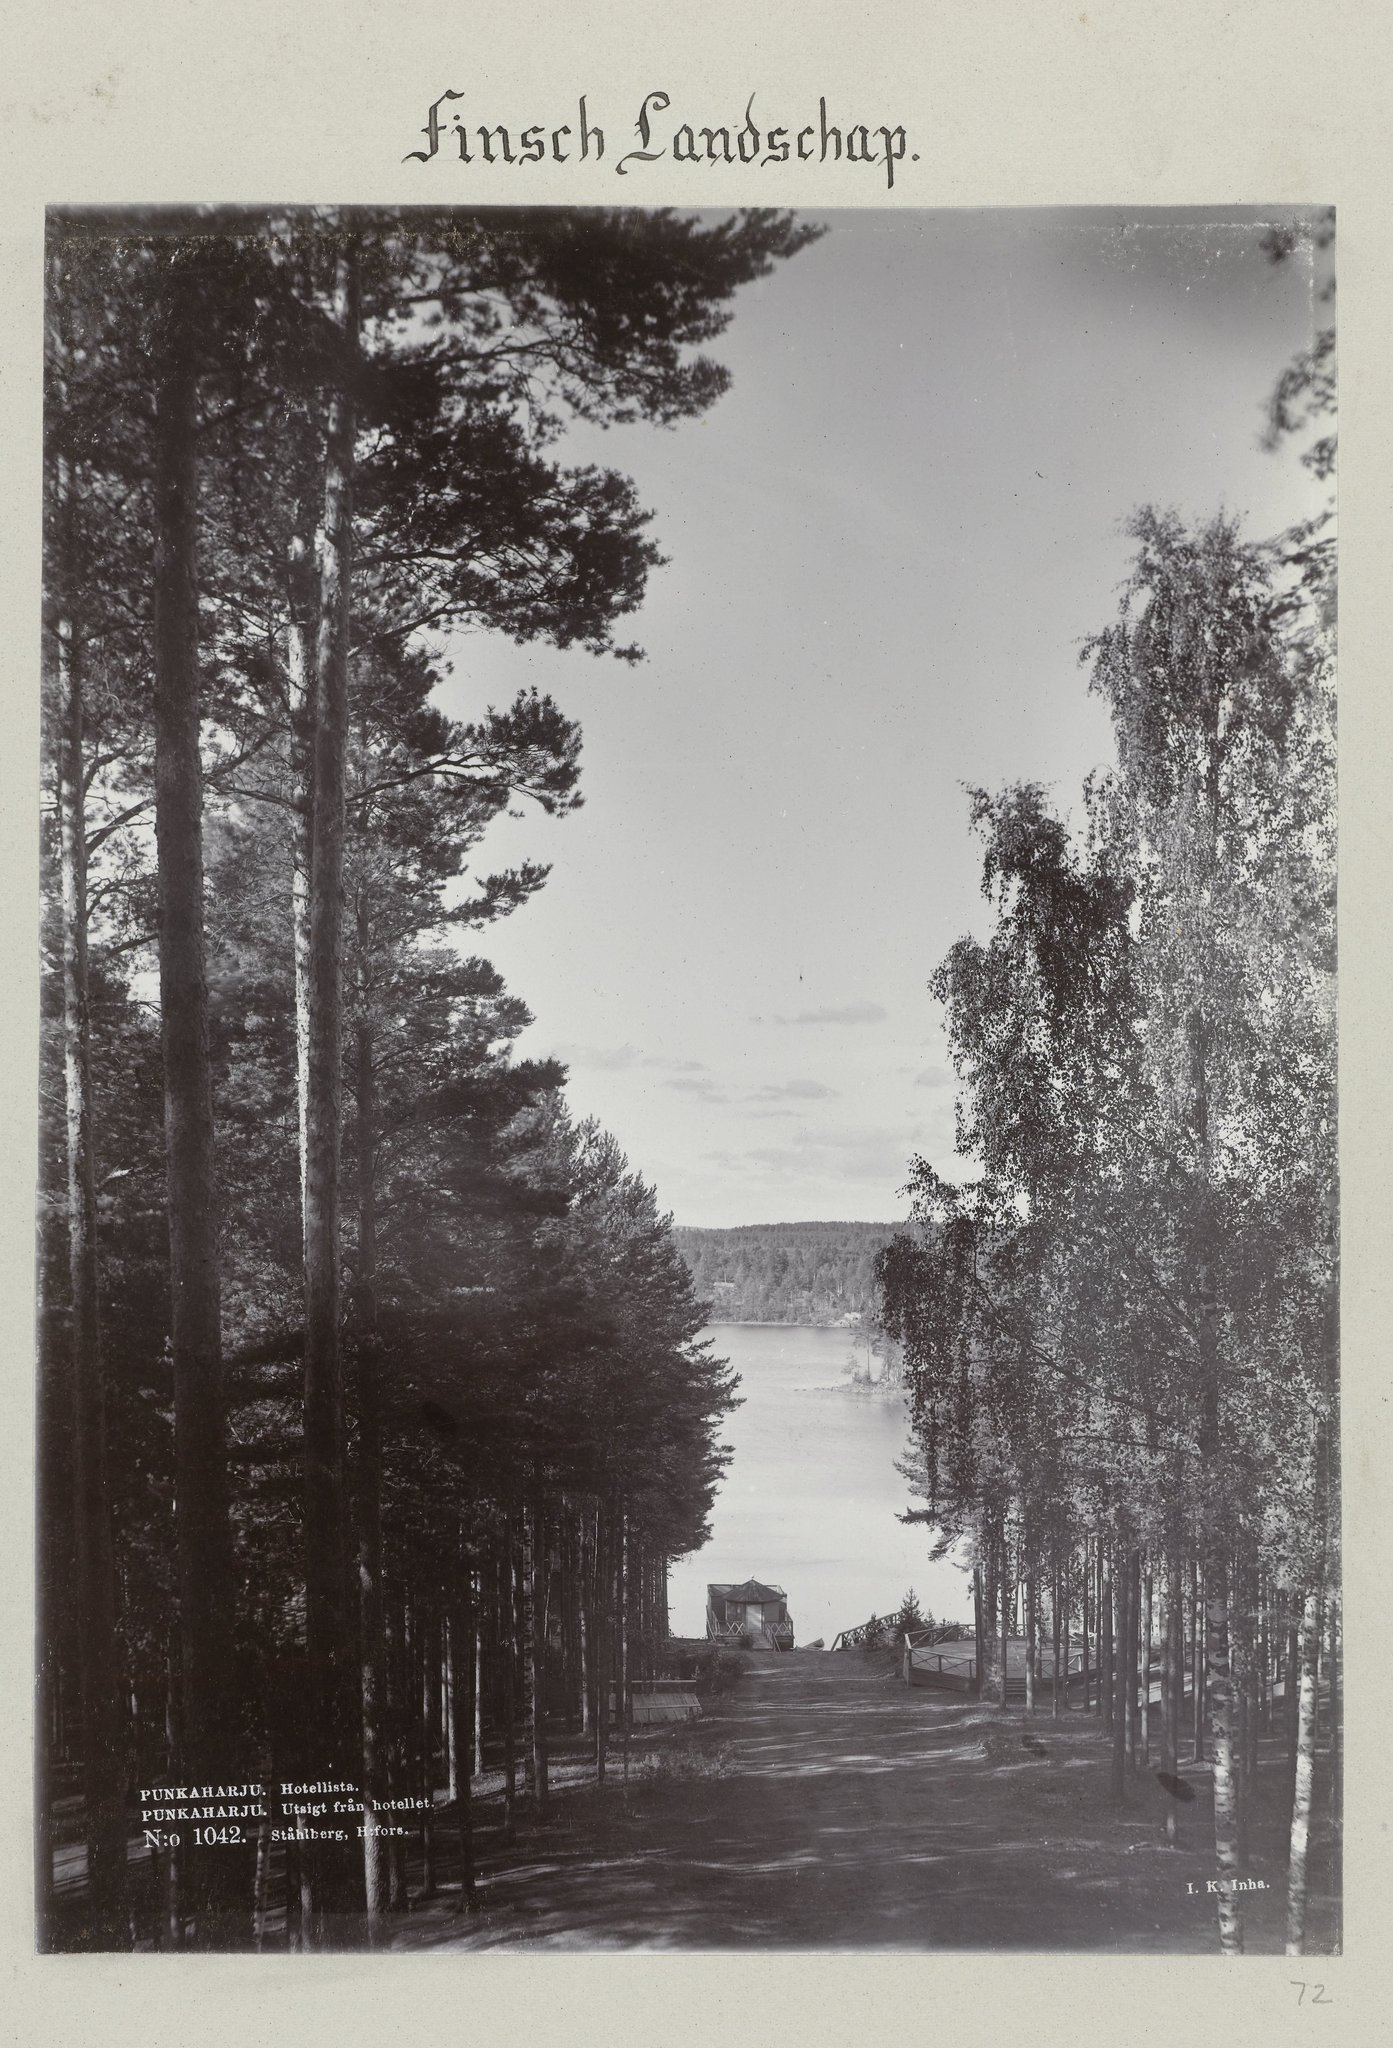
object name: photograph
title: Punkaharju Hotelista, No 1042 Stahlberg, Hfors.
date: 1898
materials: paper, photographic support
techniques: albumen print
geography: helsinki